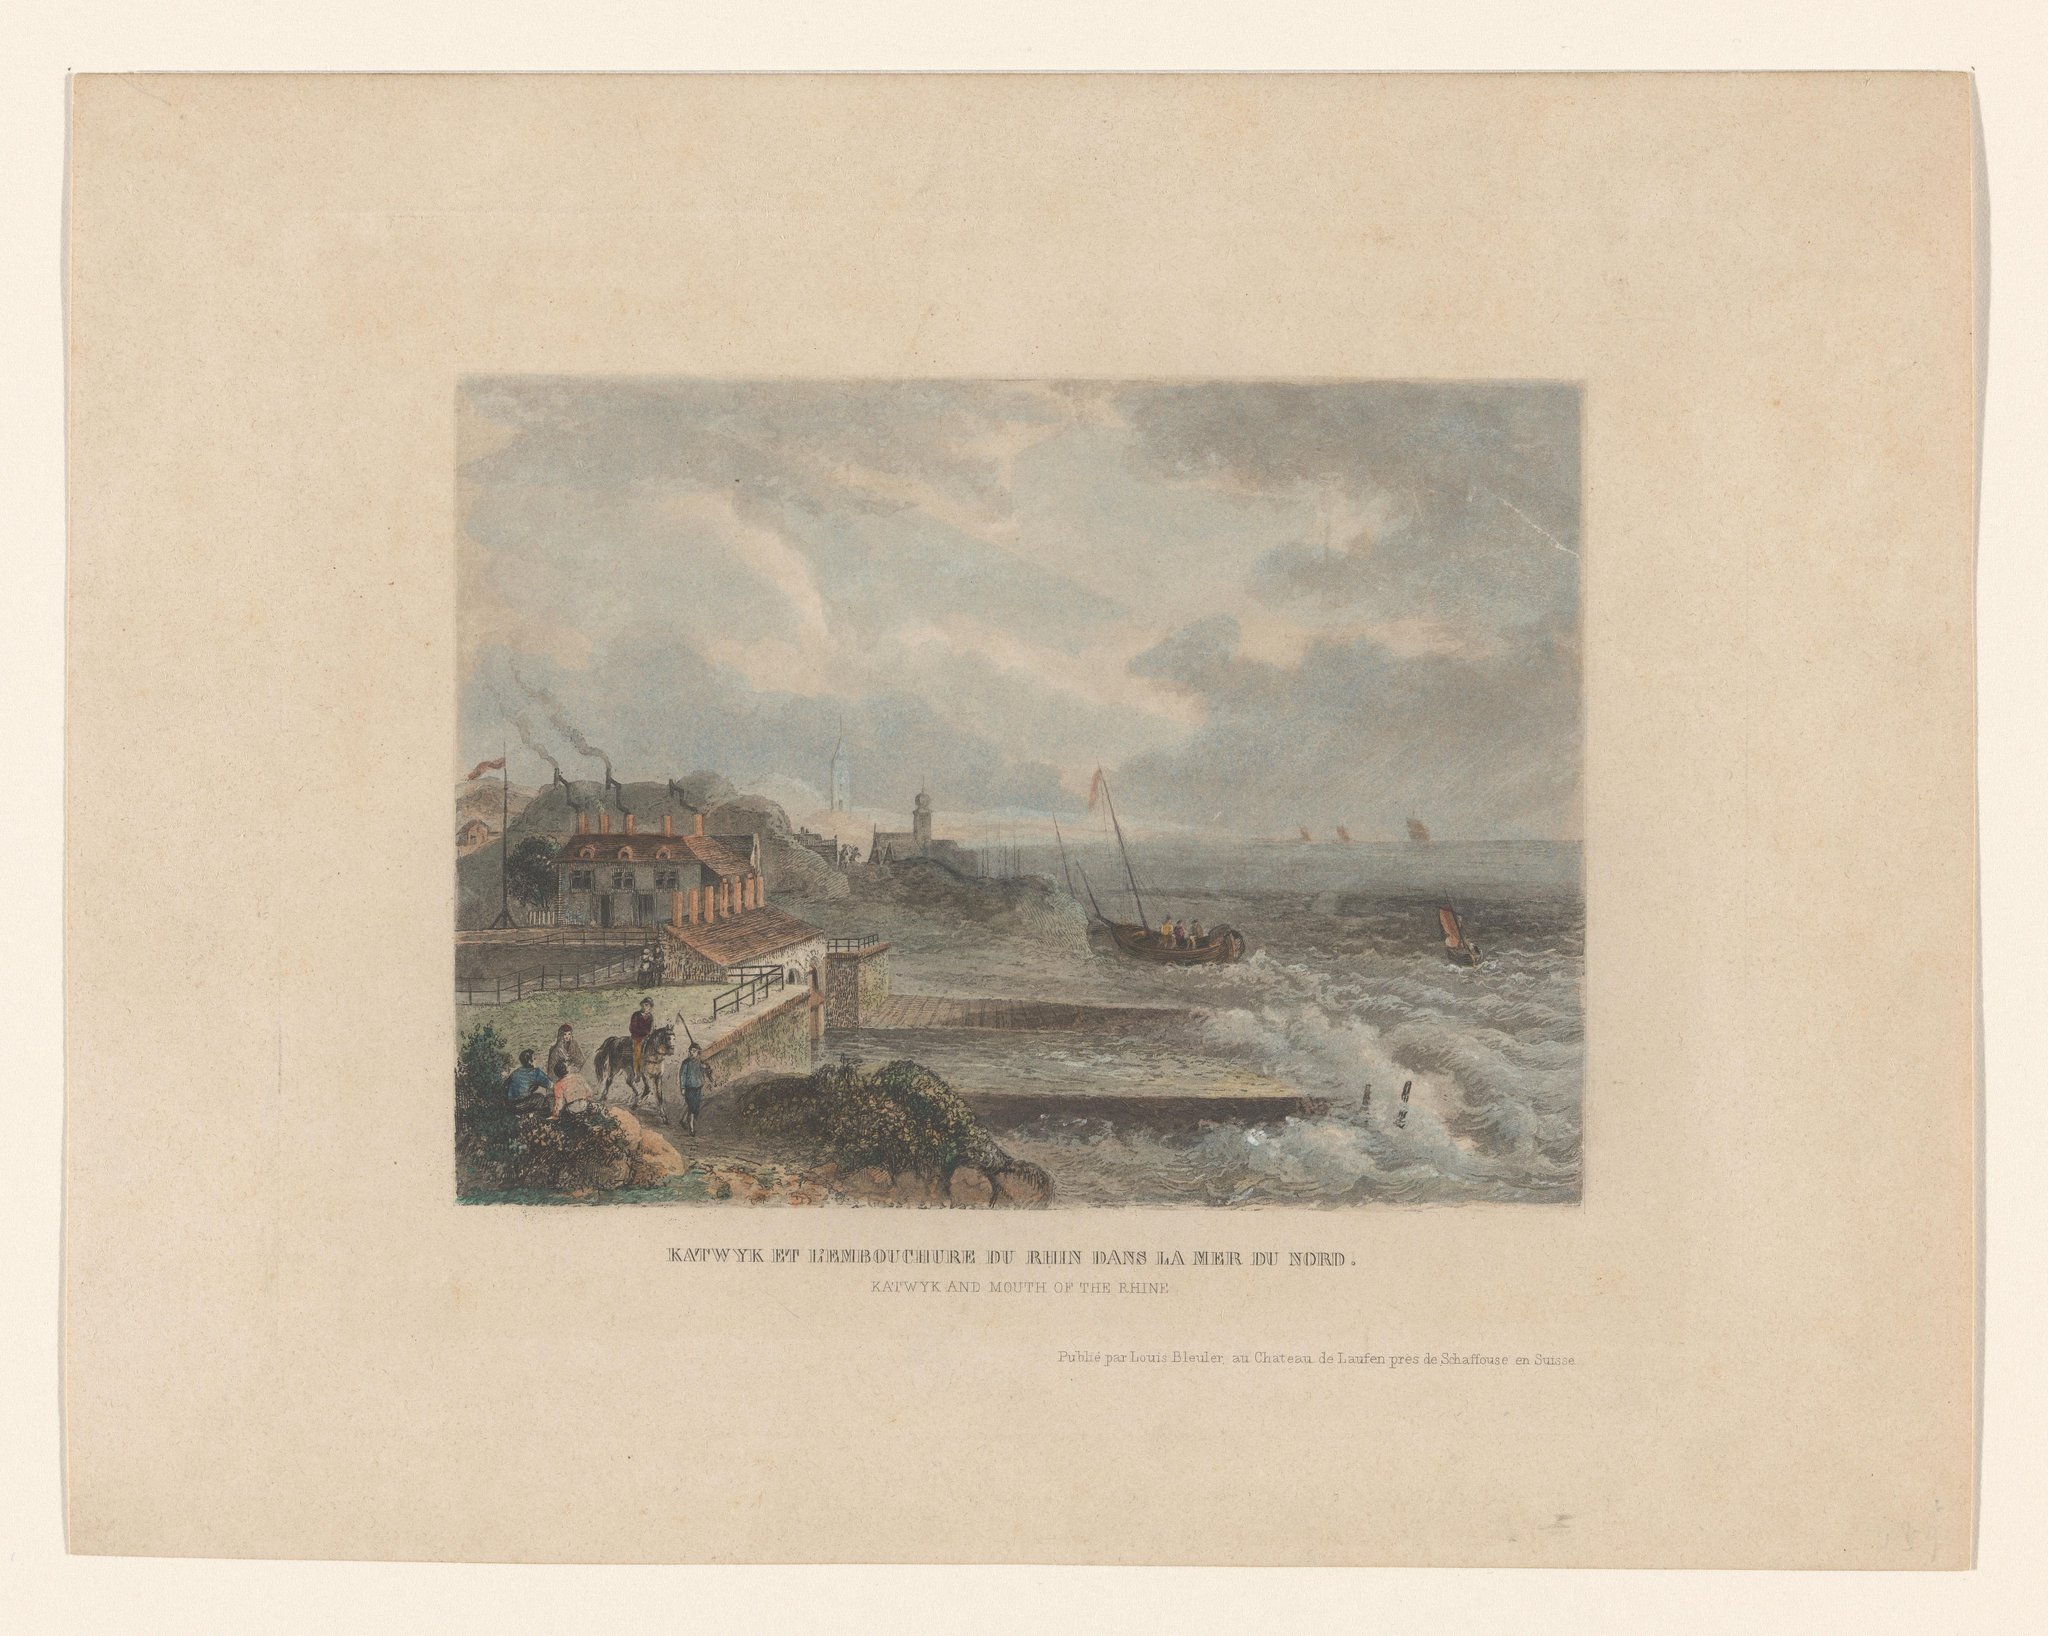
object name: print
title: Katwyk et l’embouchure du Rhin dans la mer du Nord / Katwyk and mouth of the Rhine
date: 1802-1850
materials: paper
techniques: aquatint, hand coloring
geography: schaffhausen